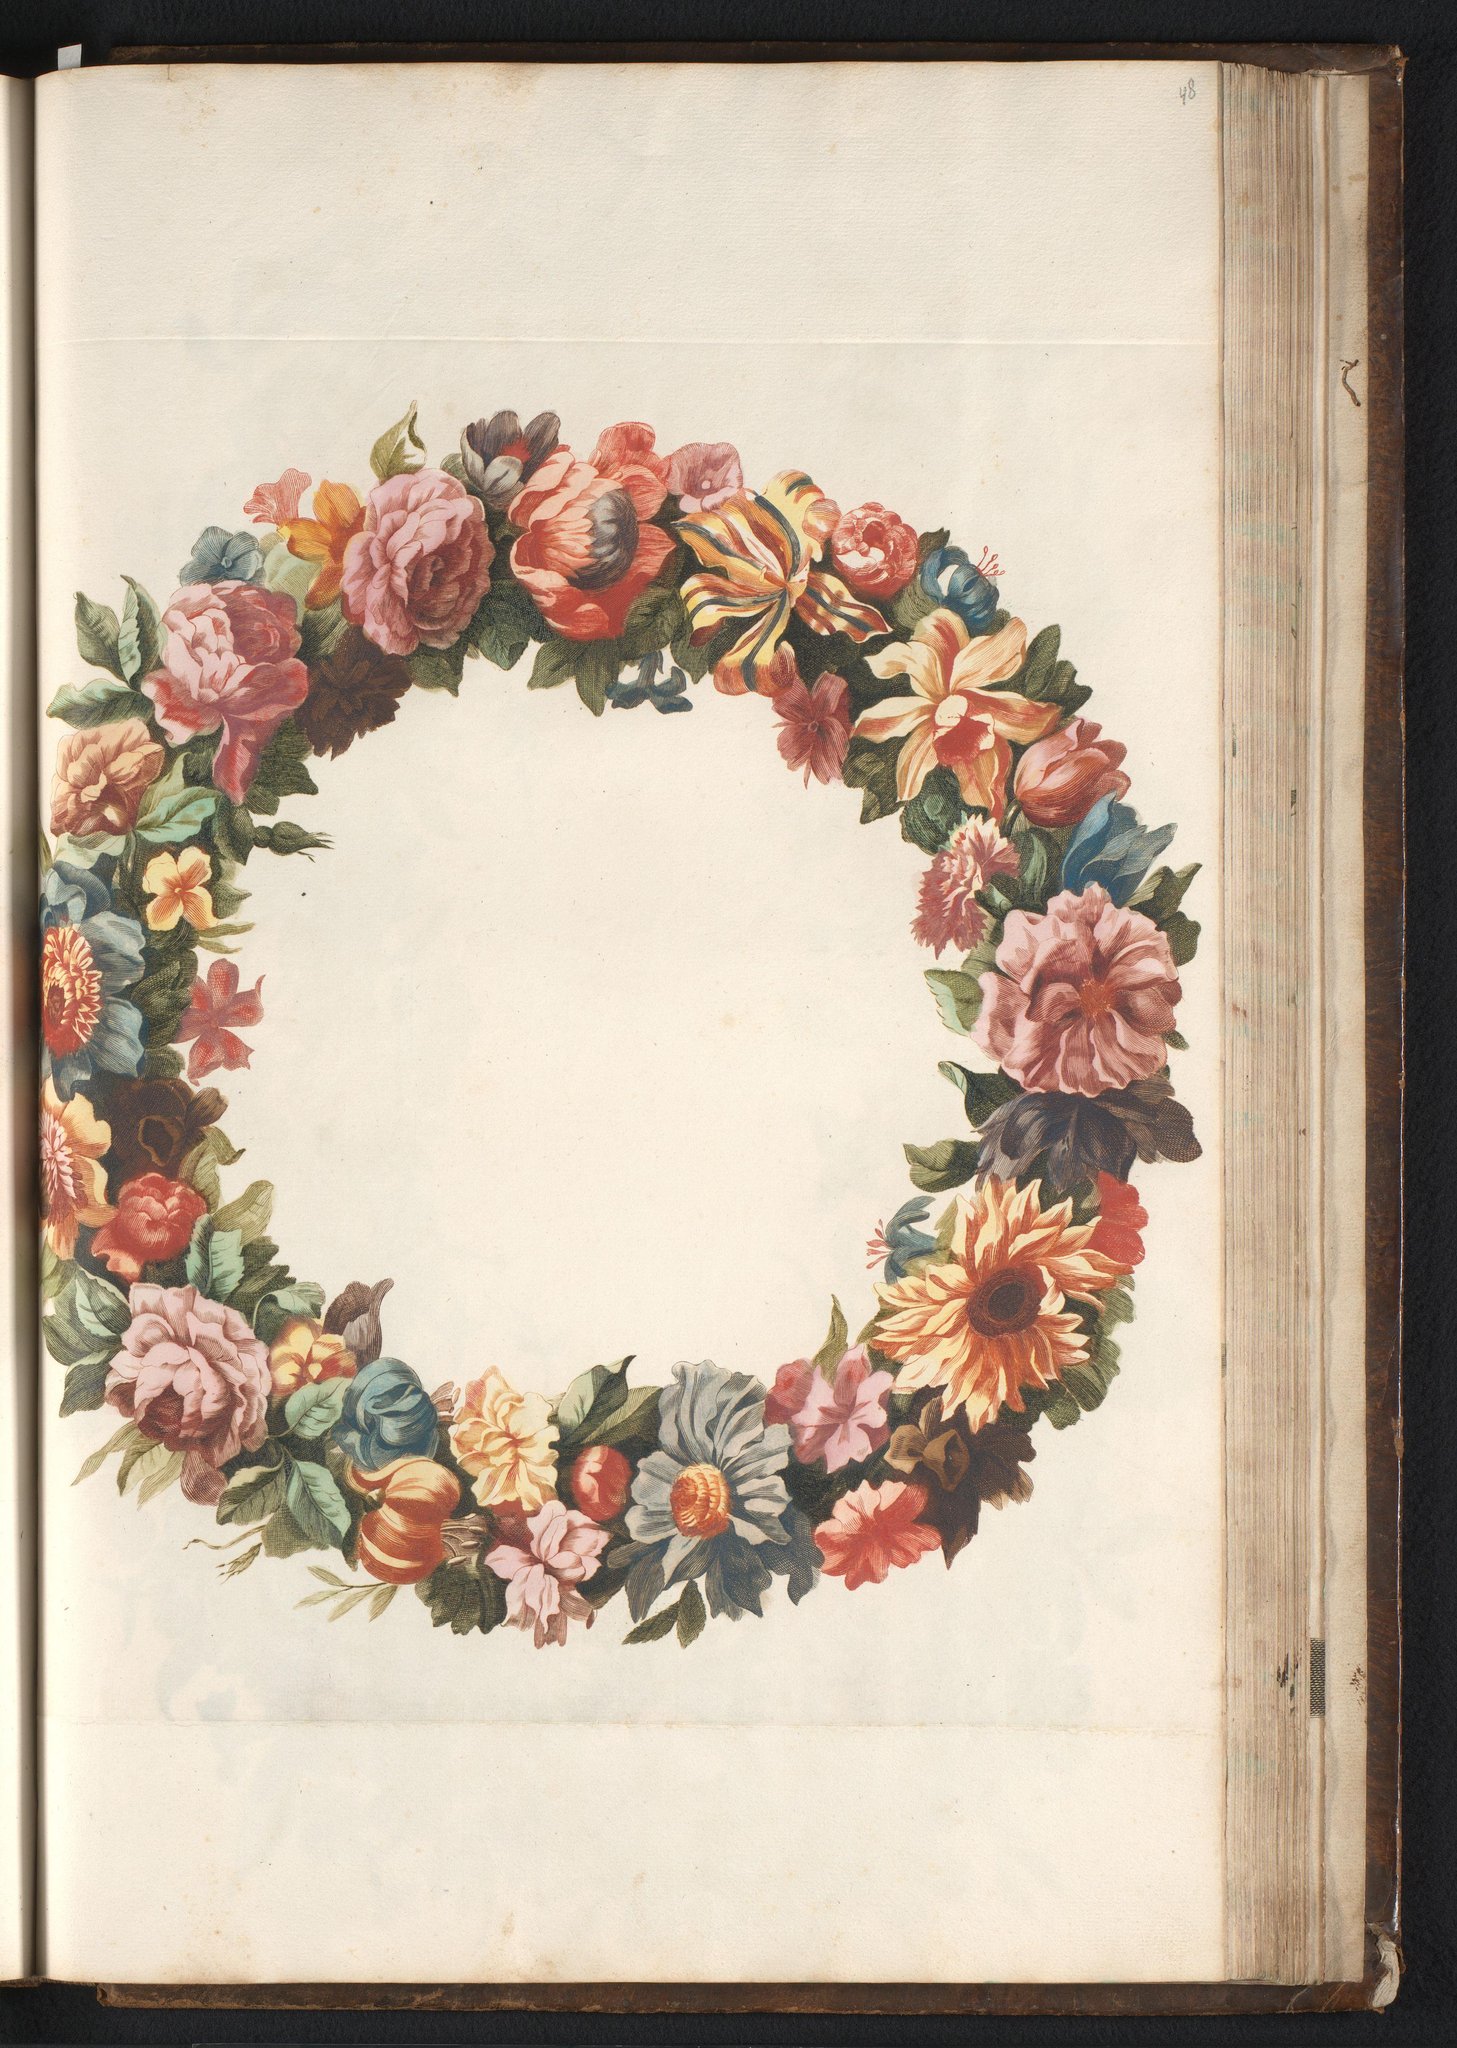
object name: print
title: Ronde bloemenkrans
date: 1688-1698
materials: paper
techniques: printing, engraving, hand coloring, lithography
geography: netherlands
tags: garland, wreath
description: Deze prent maakt deel uit van een album.